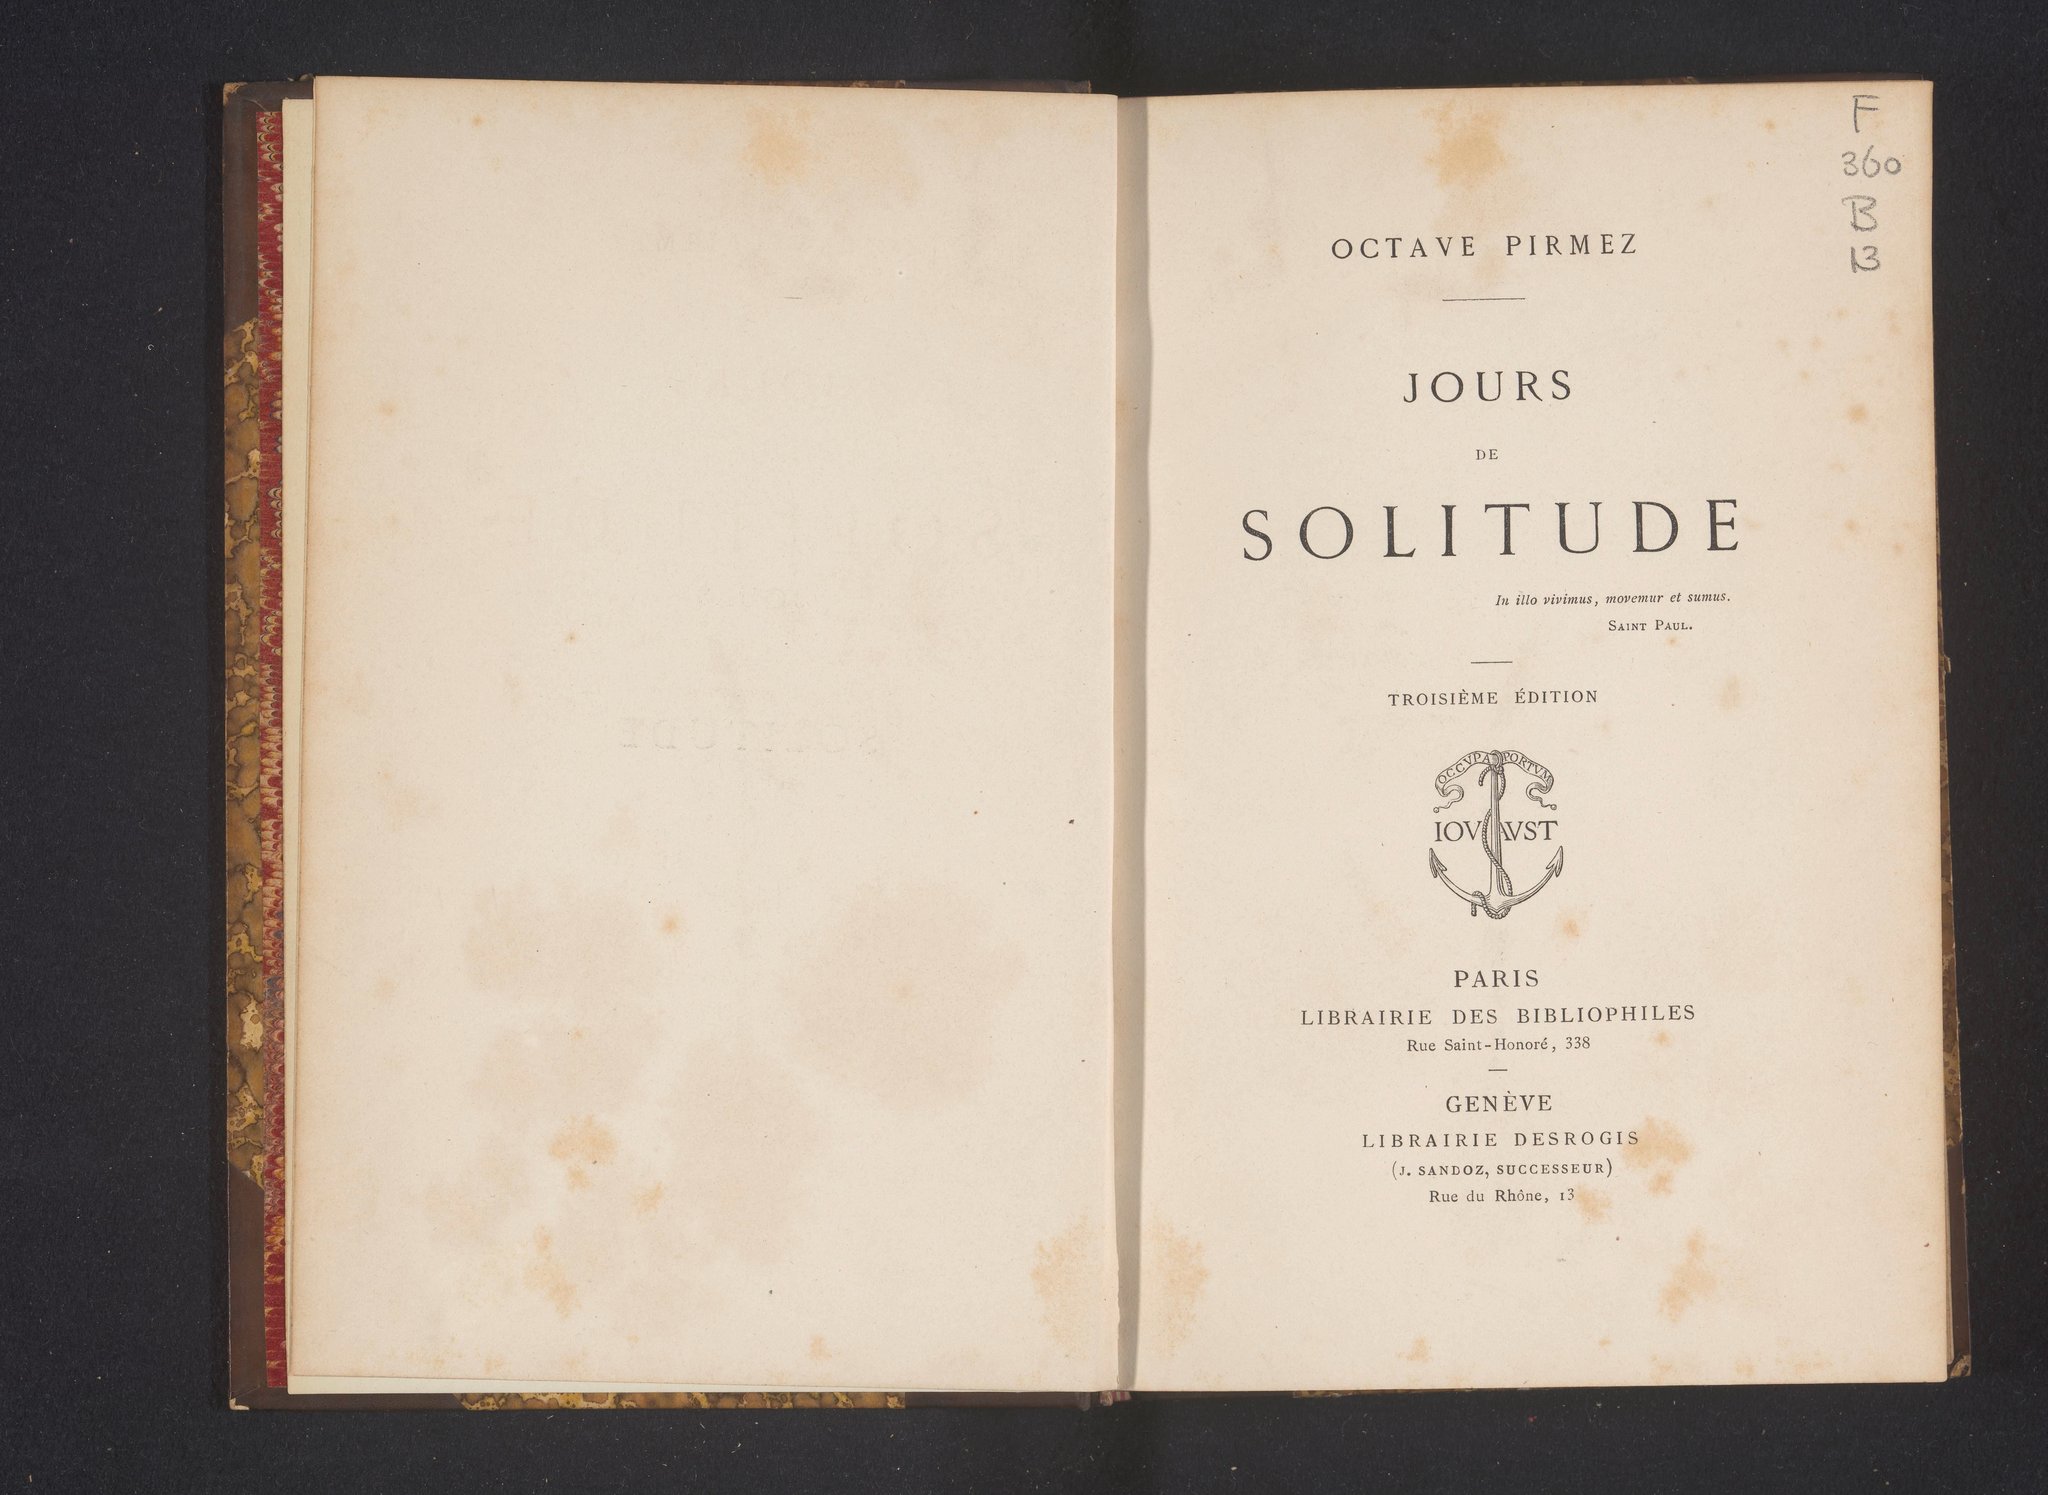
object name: book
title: Jours de solitude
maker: octave pirmez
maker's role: schrijver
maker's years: 1832-1883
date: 1877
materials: cardboard, leather, paper, photographic support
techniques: albumen print, marbled paper, printing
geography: paris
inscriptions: annotation: ‘FEB/ 1997’